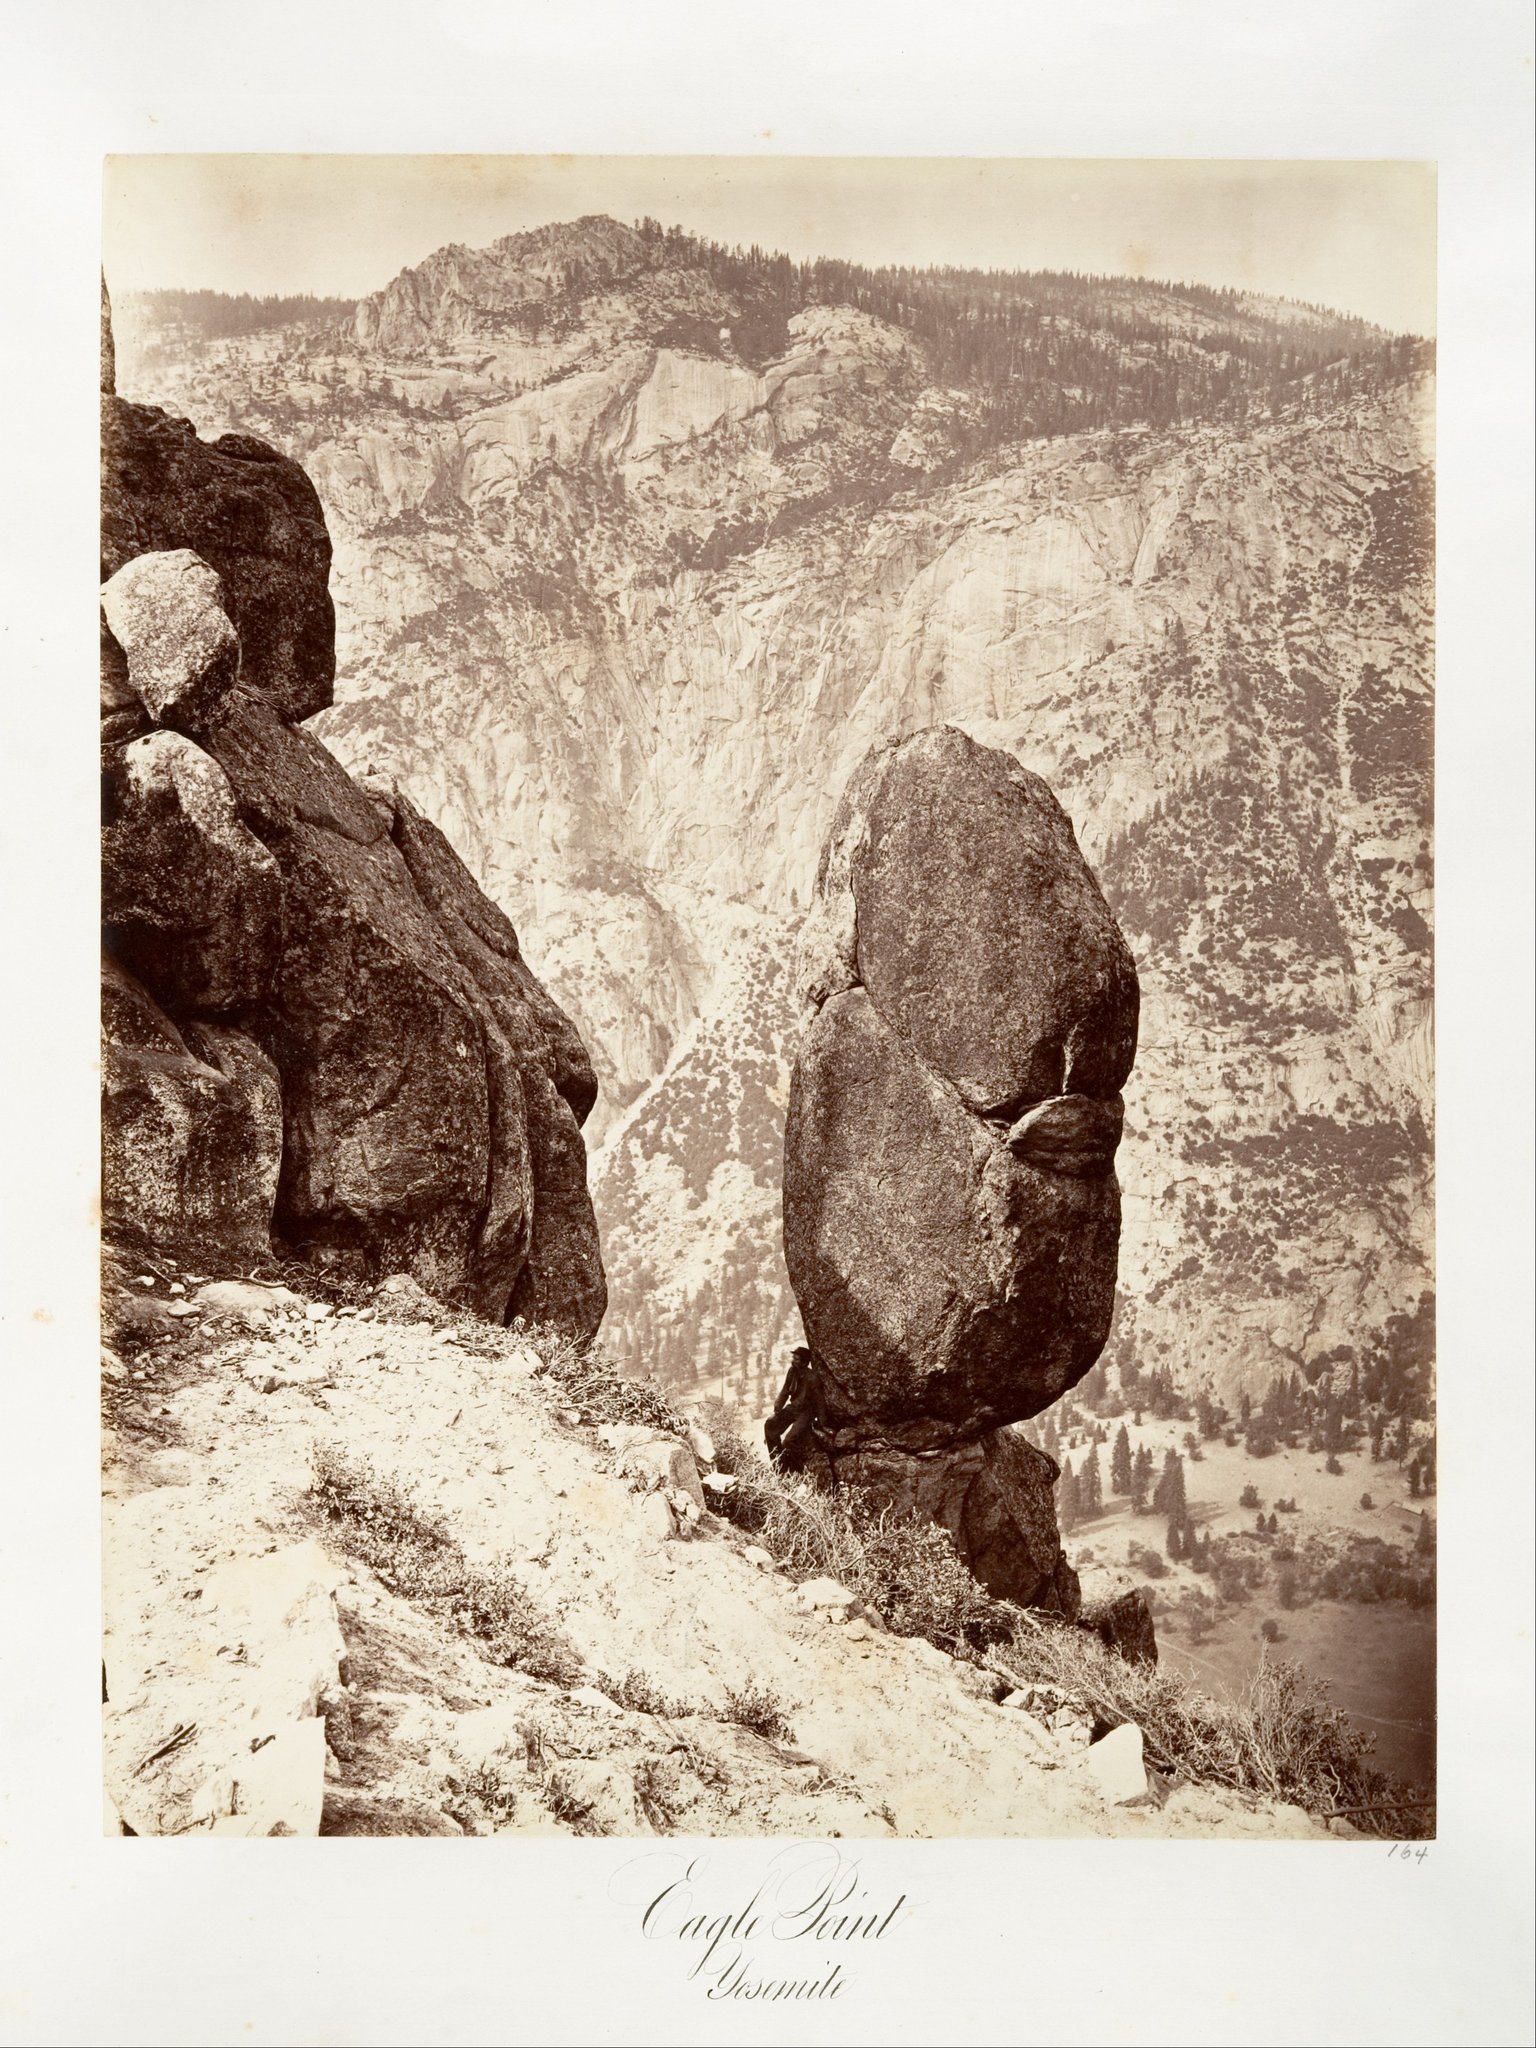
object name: photograph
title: Eagle Point, Yosemite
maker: carleton e. watkins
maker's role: artist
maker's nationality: american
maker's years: 1829-1916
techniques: albumen silver print, glass negative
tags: mountains,landscapes